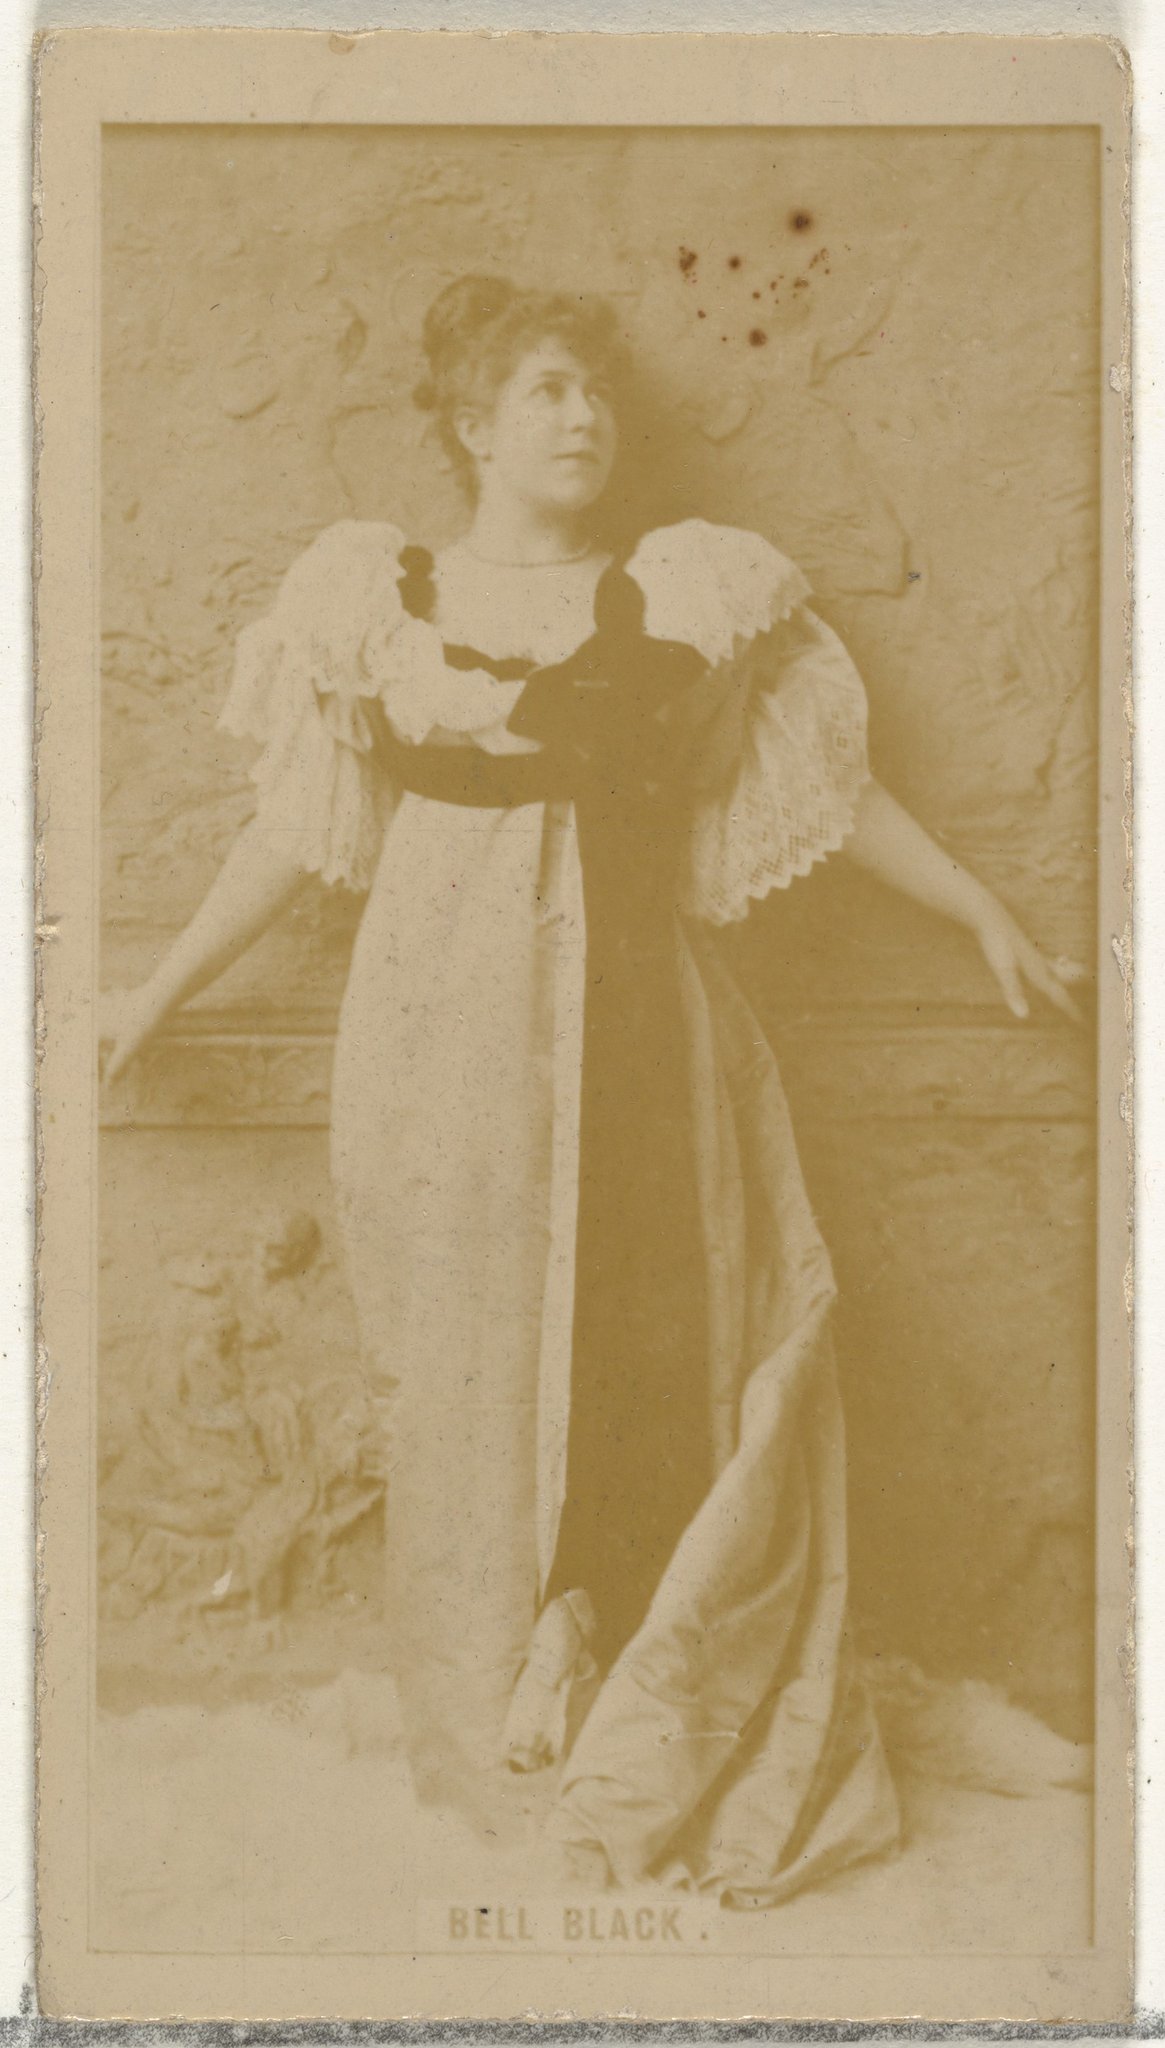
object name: photograph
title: Bell Black, from the Actors and Actresses series (N145-8) issued by Duke Sons & Co. to promote Duke Cigarettes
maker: w. duke, sons & co.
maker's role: publisher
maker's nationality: american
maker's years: 1870-1920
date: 1891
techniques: albumen silver print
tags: portraits,women,actresses